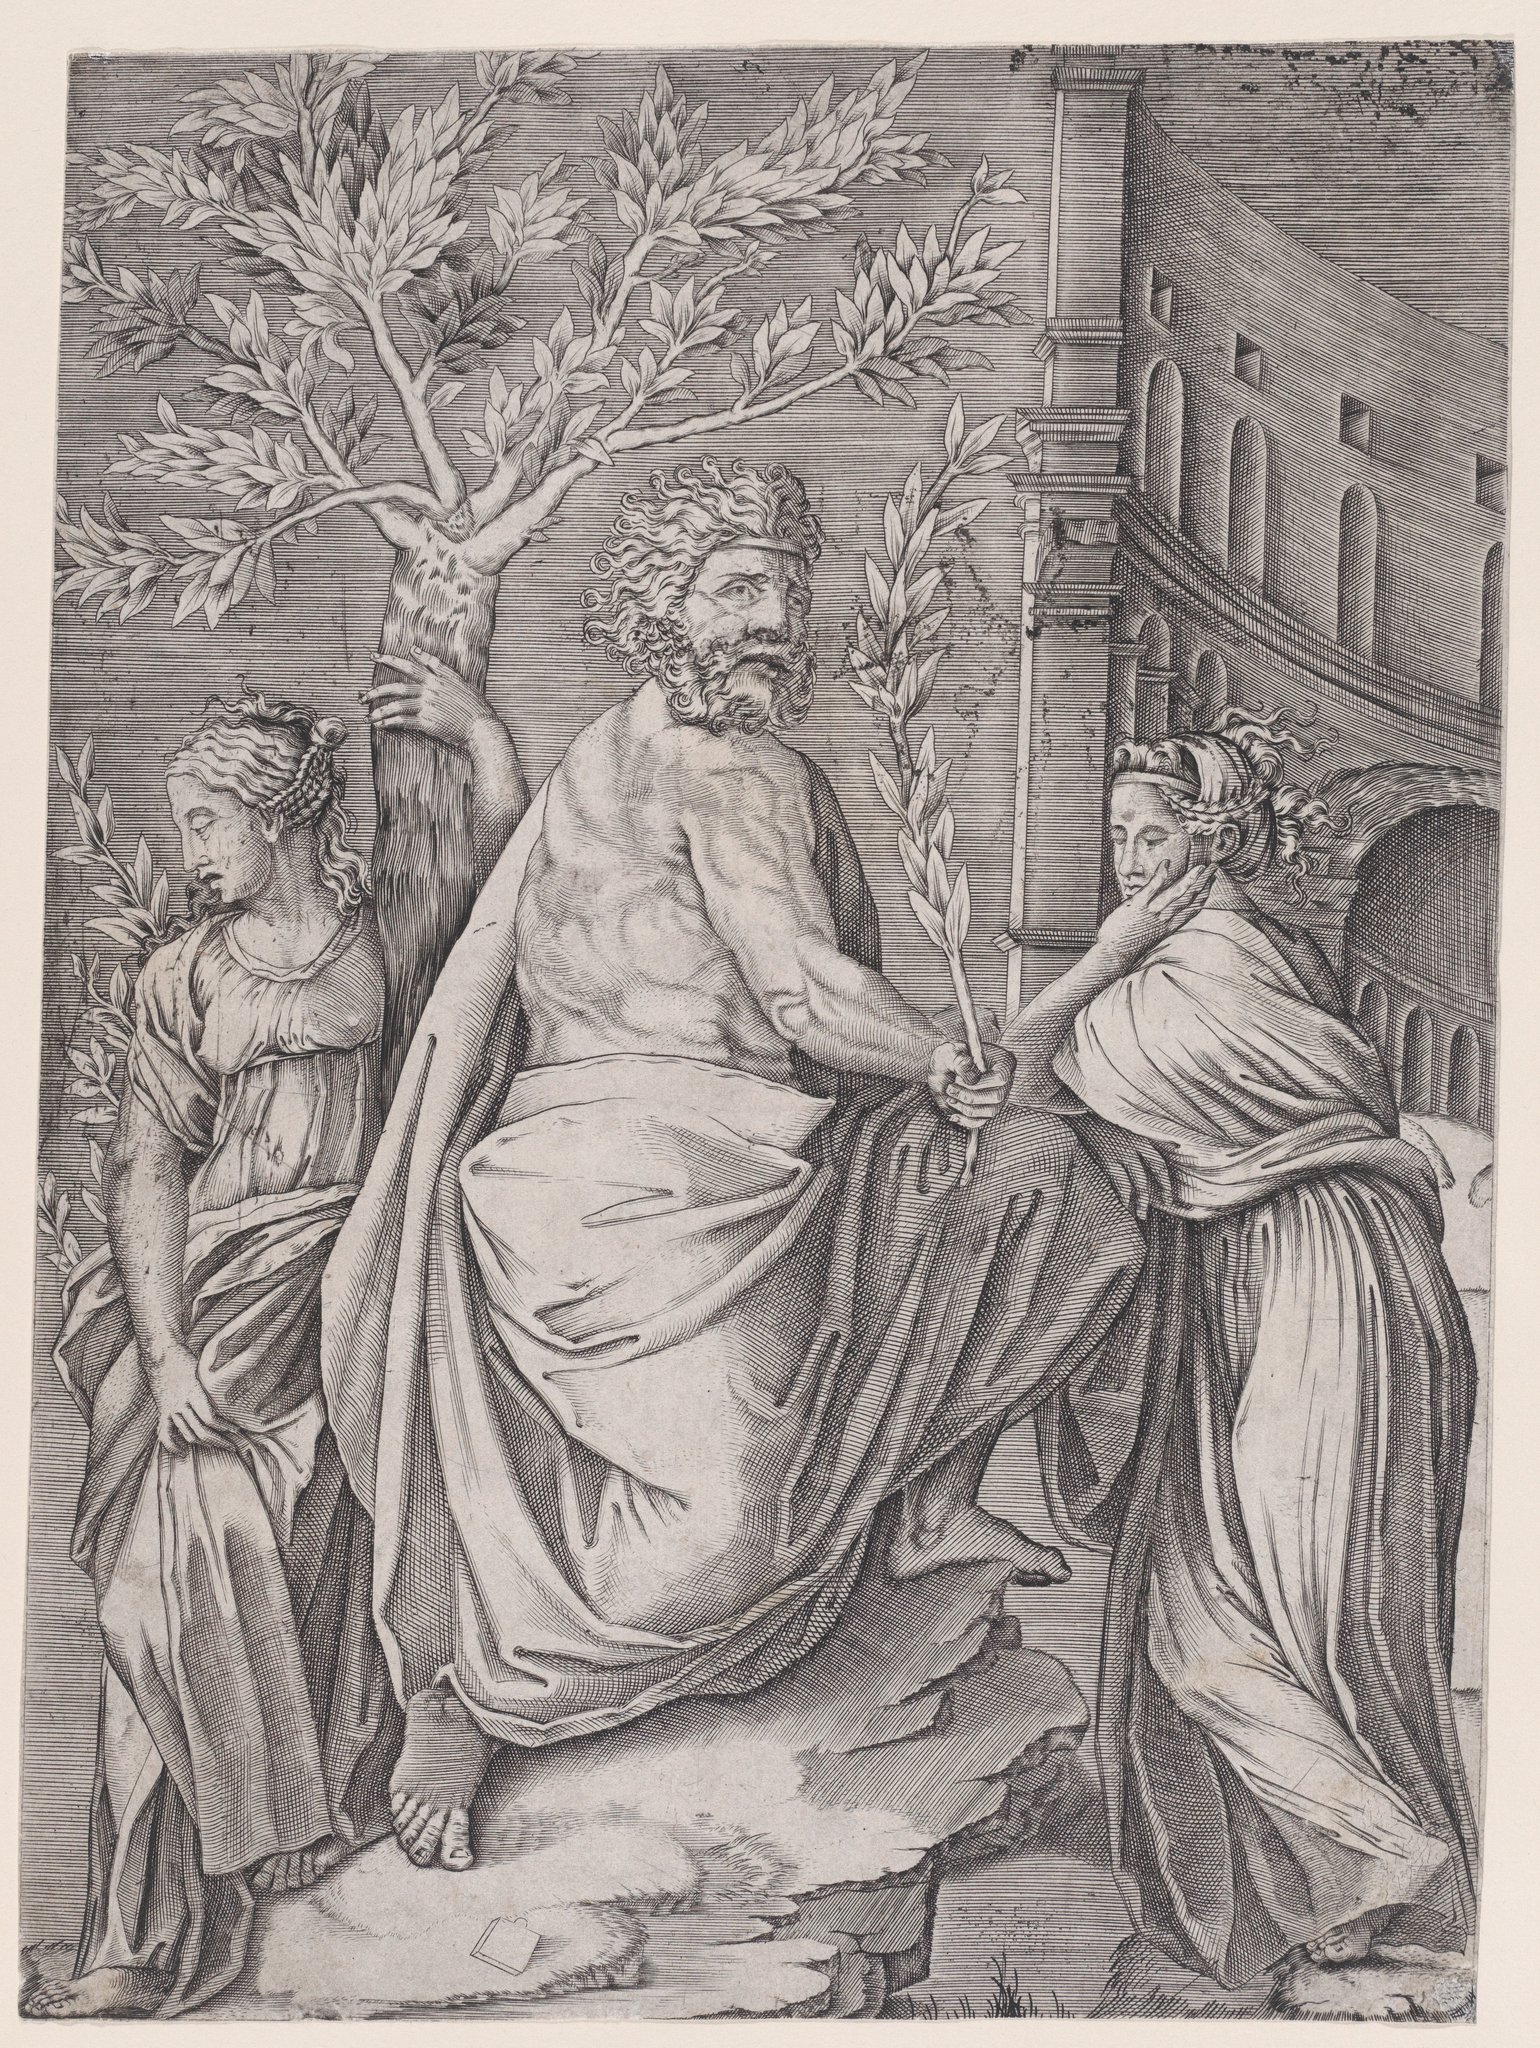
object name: print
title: The Man with a Laurel Branch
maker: agostino veneziano (agostino dei musi)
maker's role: artist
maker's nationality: italian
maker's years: 1490-1536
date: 1514-1536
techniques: engraving